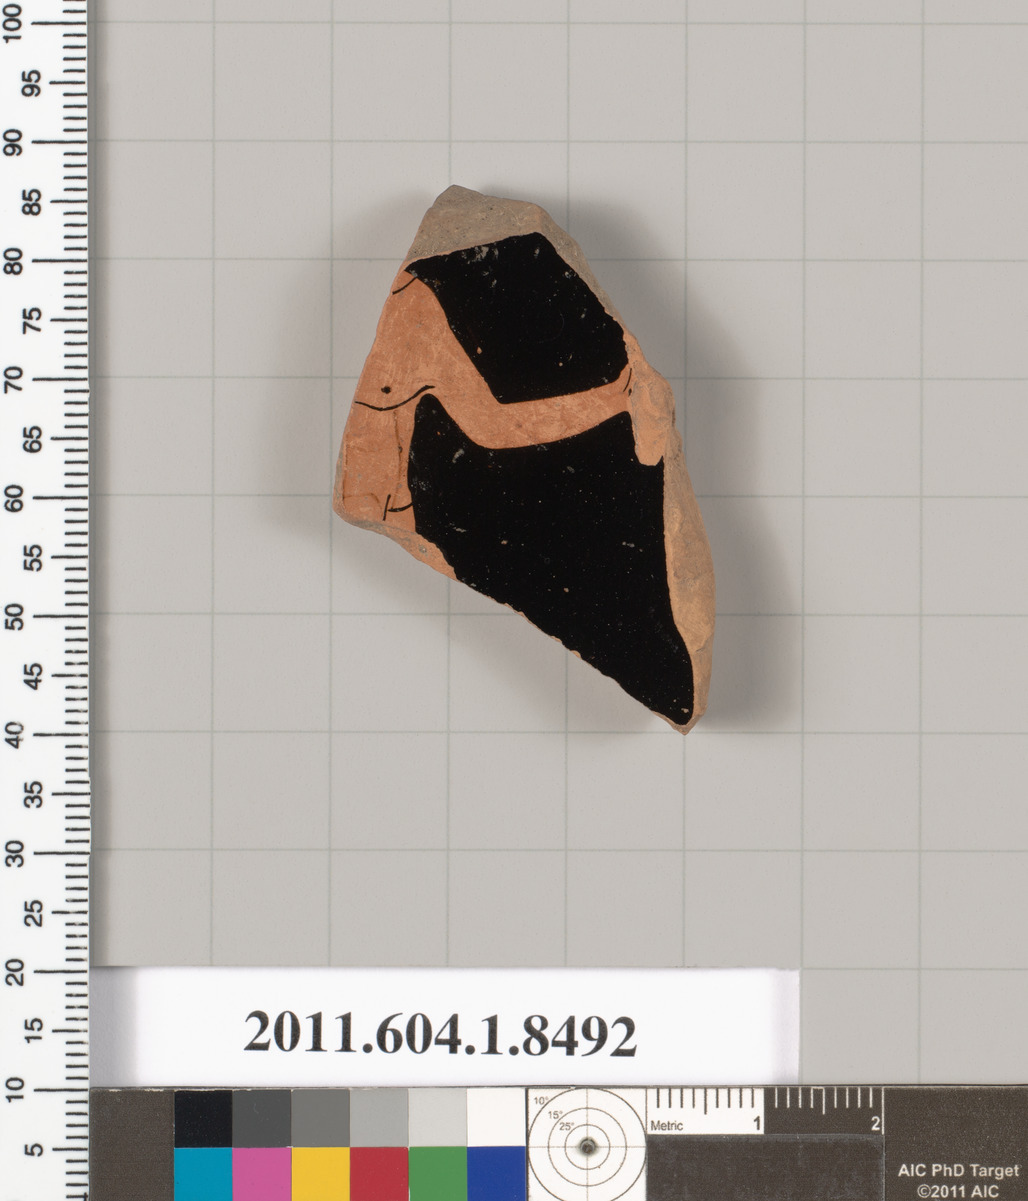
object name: kylix fragment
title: Terracotta fragment of a stemless kylix (drinking cup)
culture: greek, attic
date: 475-451 BCE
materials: terracotta